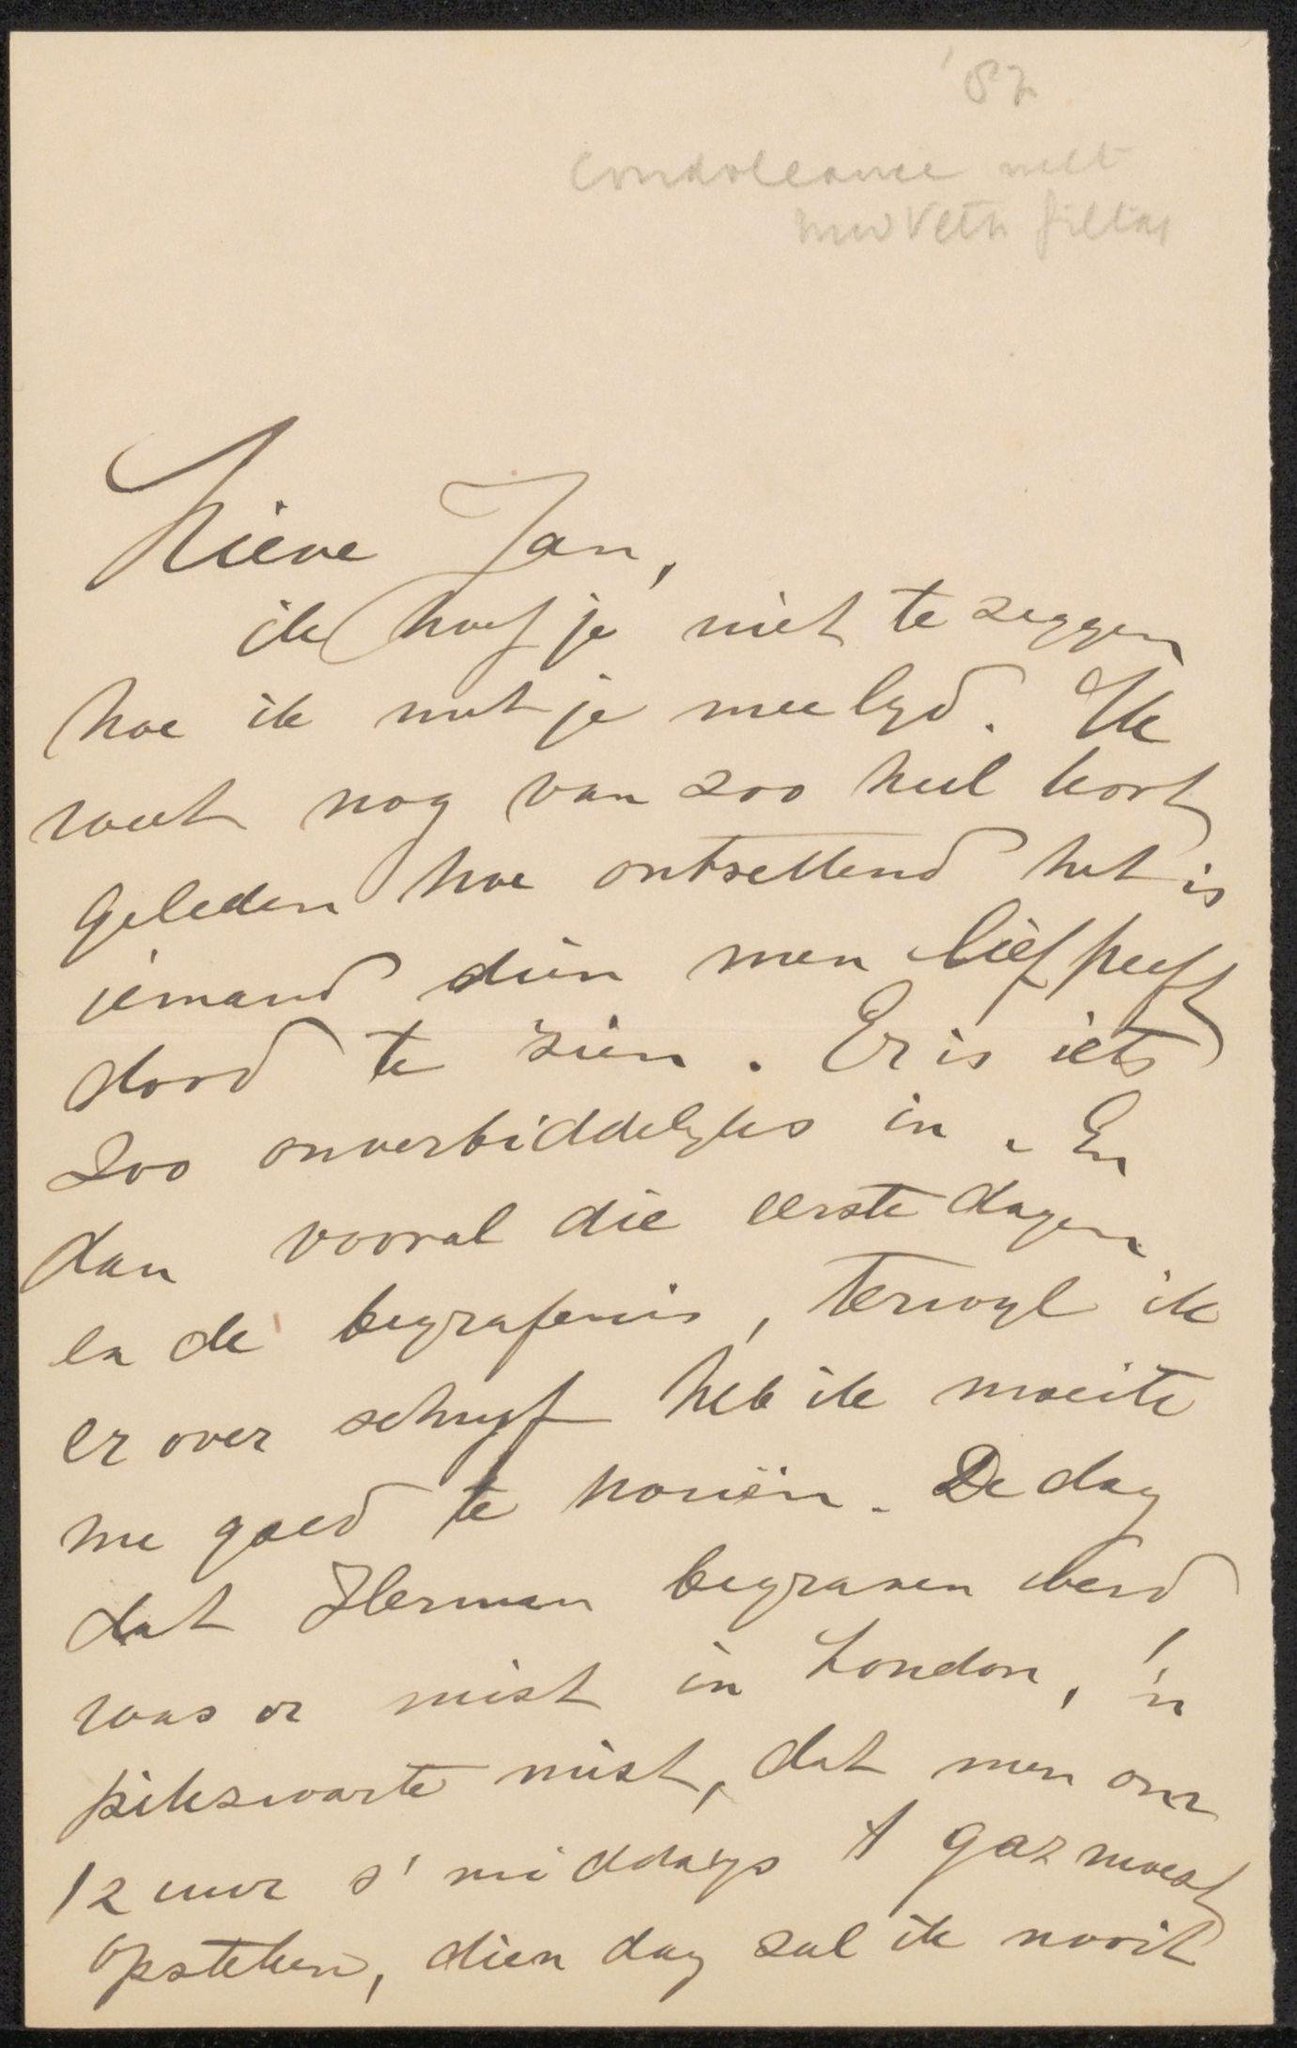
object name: letter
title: Brief aan Jan Veth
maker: wally moes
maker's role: draughtsman, print maker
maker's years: 1856-1918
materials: ink, paper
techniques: pen, writing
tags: dordrecht, painter, print maker, draughtsman, designer, jan veth, passions, emotions, affections, family life, london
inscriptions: collector's mark: ‘RPK’